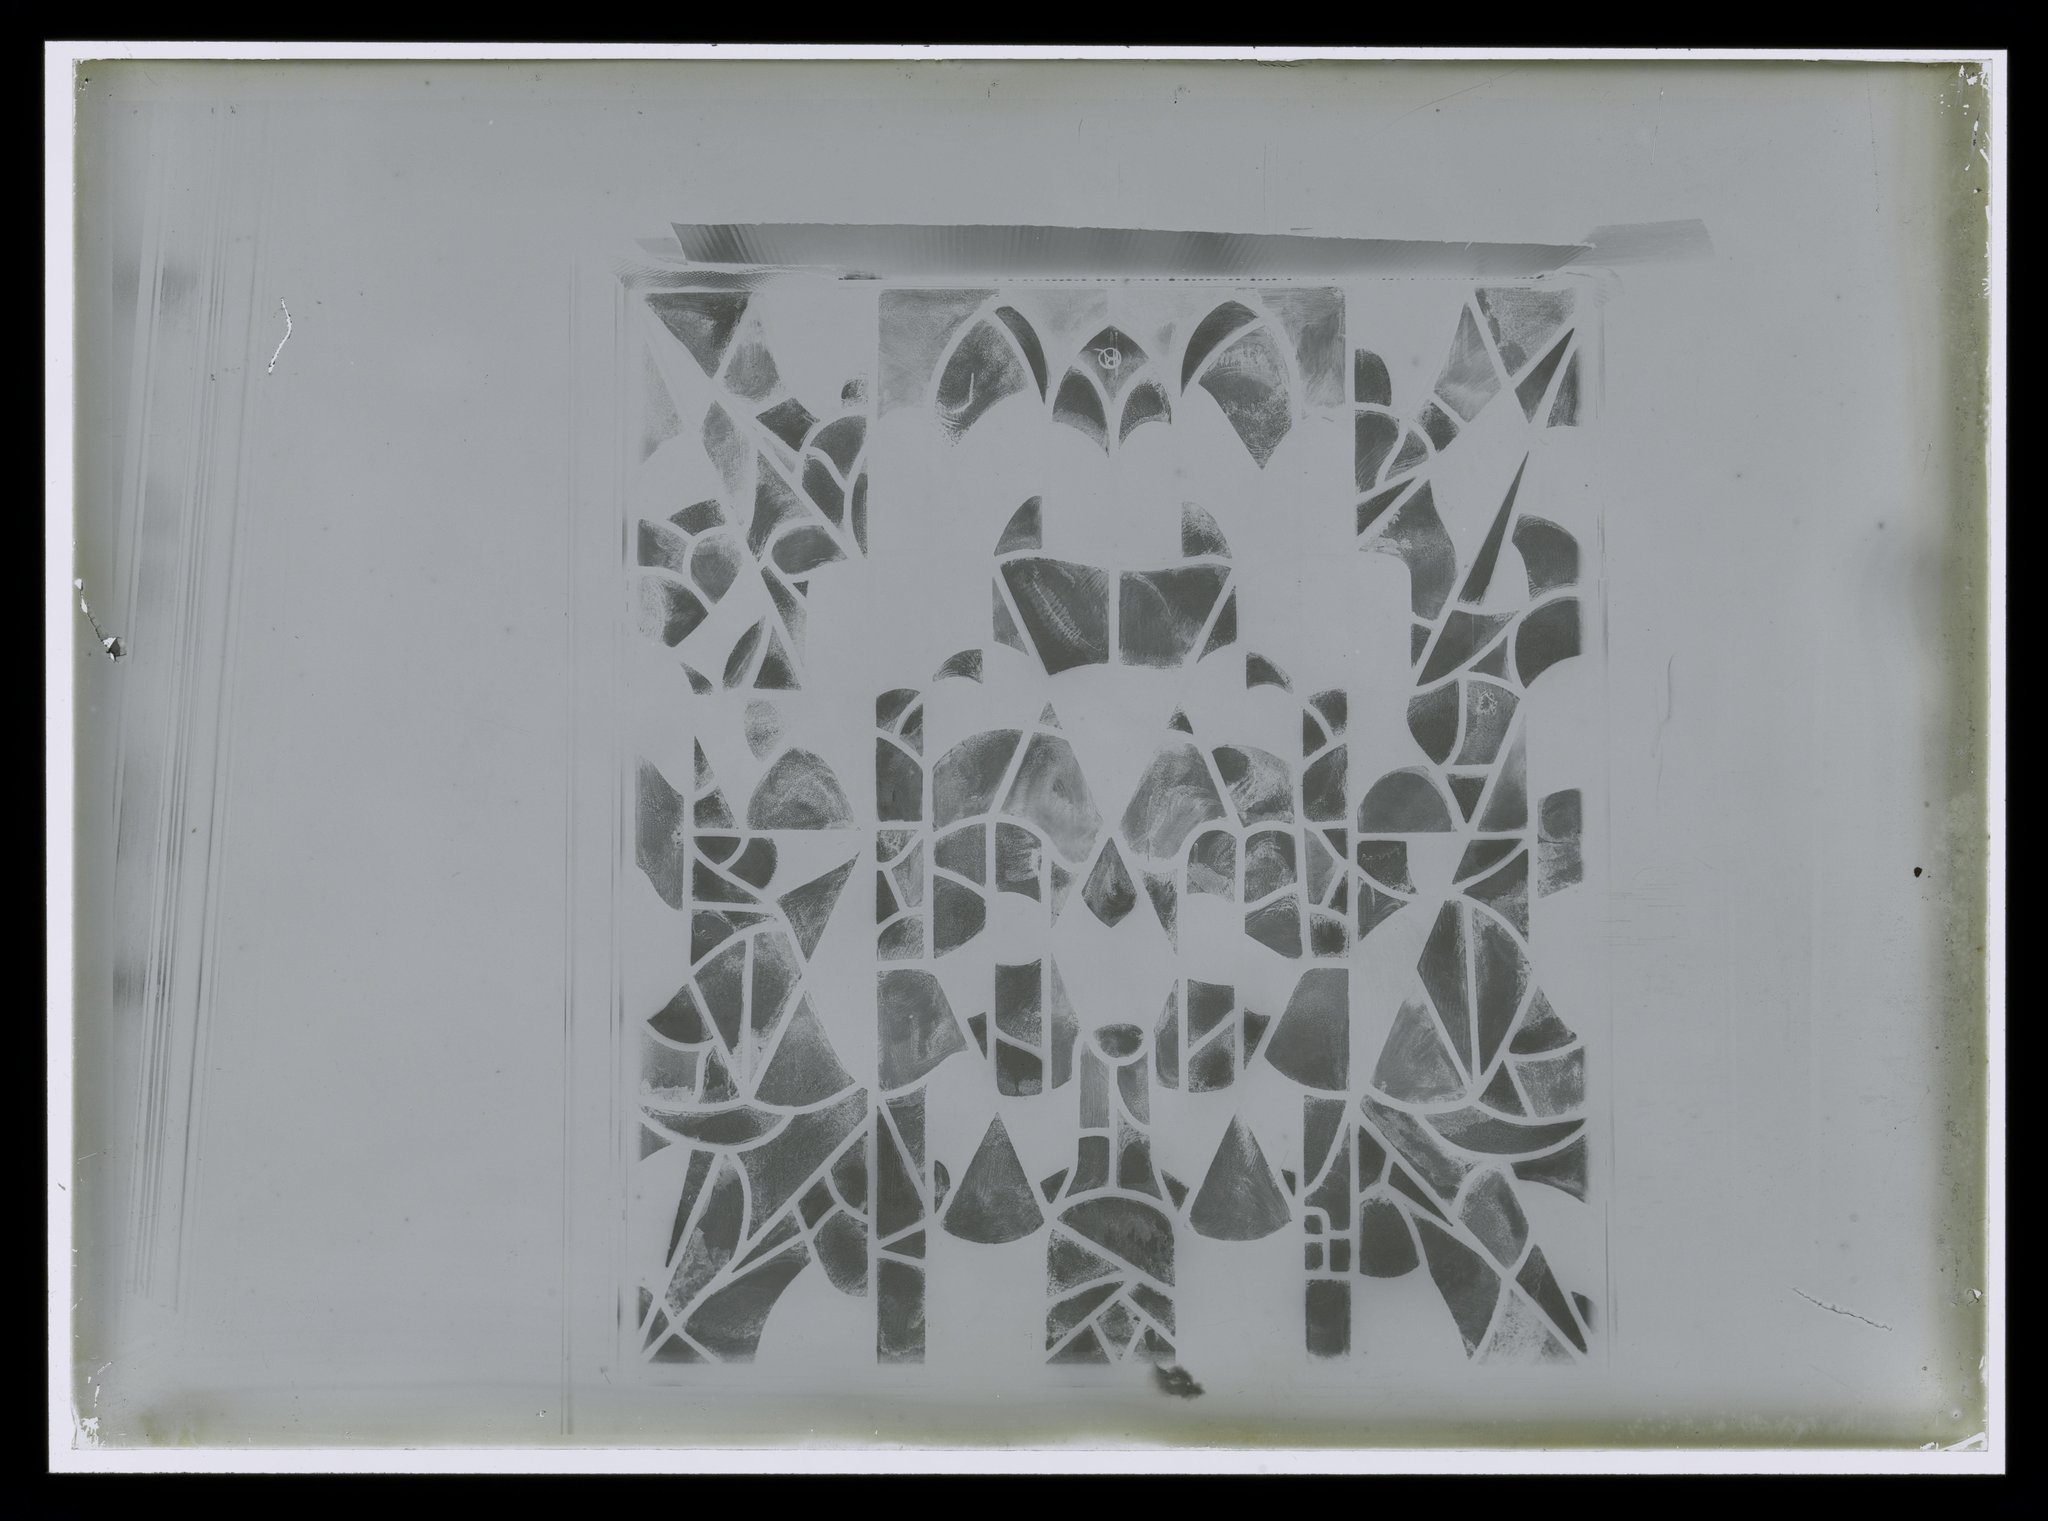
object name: reproduction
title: Fotoreproductie van een non-figuratief gebrandschilderd glas-in-loodraam gemaakt door Richard Nicolaüs Roland Holst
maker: Anonymous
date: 1925-1939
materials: glass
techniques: gelatin glass negative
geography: amsterdam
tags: window, glass ~ building material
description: Het glas-in-loodraam is één van de ramen bestemd voor het trappenhuis van de Universiteitsbibliotheek Amsterdam, de aula van de Rijksacademie van Beeldende Kunsten of een Amsterdams gemeentegebouw.